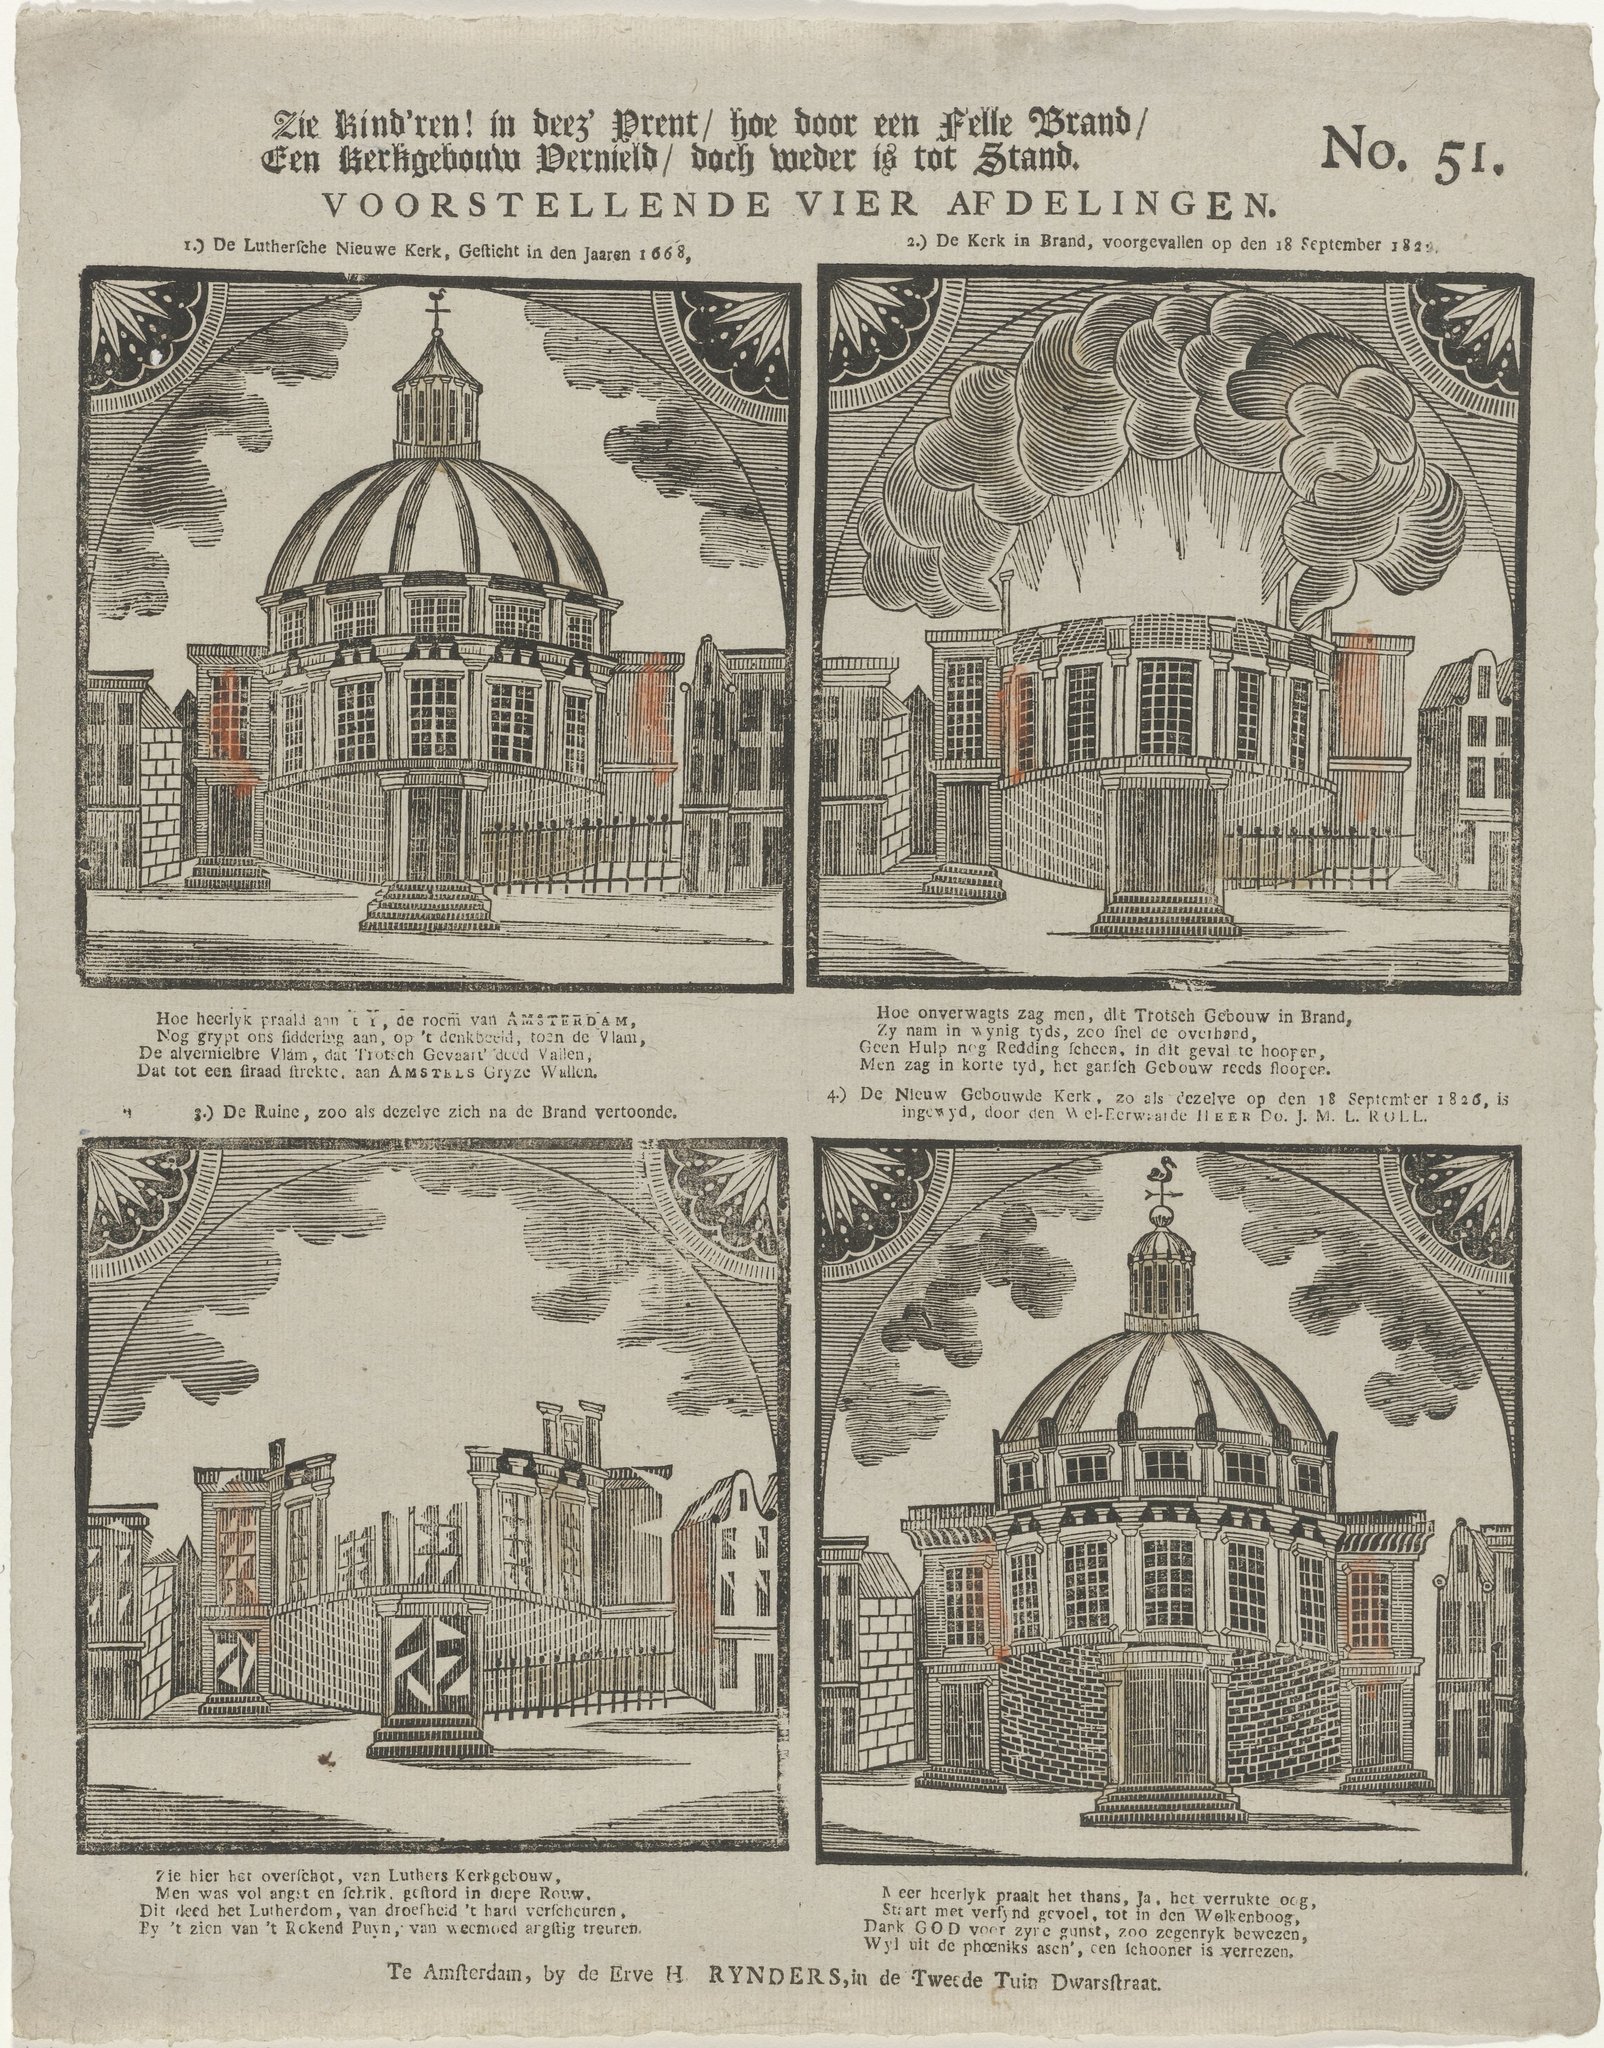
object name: print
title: Zie kind'ren! in deez' prent / hoe door een felle brand / Een kerkgebouw vernield / doch weder is tot stand / Voorstellende vier afdelingen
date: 1831-1854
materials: paper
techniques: colour, letterpress printing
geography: amsterdam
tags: church (exterior), burning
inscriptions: collector's mark: Lugt 2760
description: Blad met 4 voorstellingen van verschillende toestanden van de Ronde Lutherse Kerk in Amsterdam, waaronder de kerk in brand op 18 september 1822, als een ruïne en opnieuw opgebouwd. Onder elke afbeelding een vierregelig vers en boven elke afbeelding een nummer en een titel. Genummerd rechtsboven: No. 51.